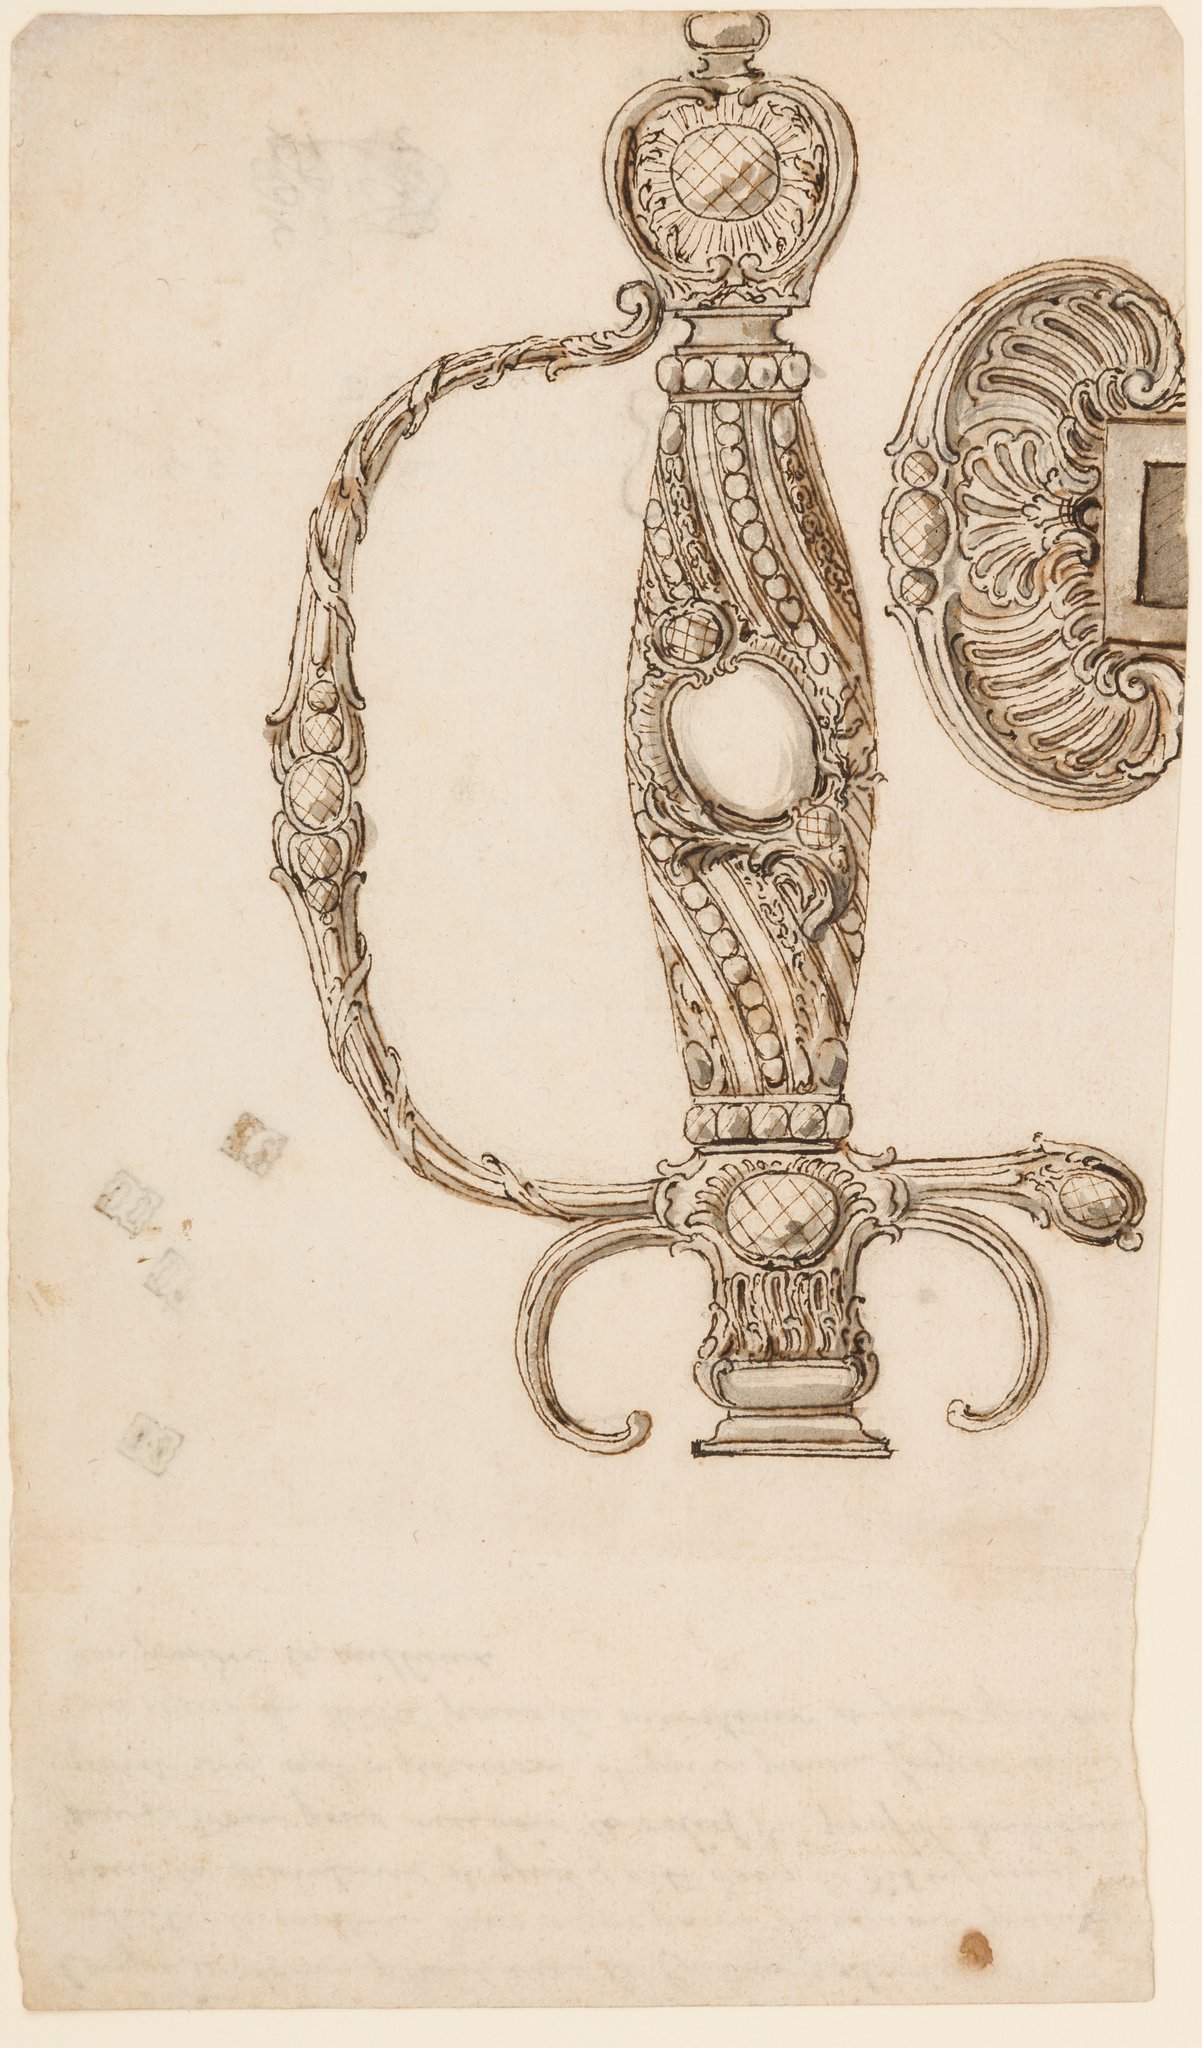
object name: four drawing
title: Set of Four Designs for Smallswords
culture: french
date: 1725-1780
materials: ink, paper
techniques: pen, wash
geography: france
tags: hilts